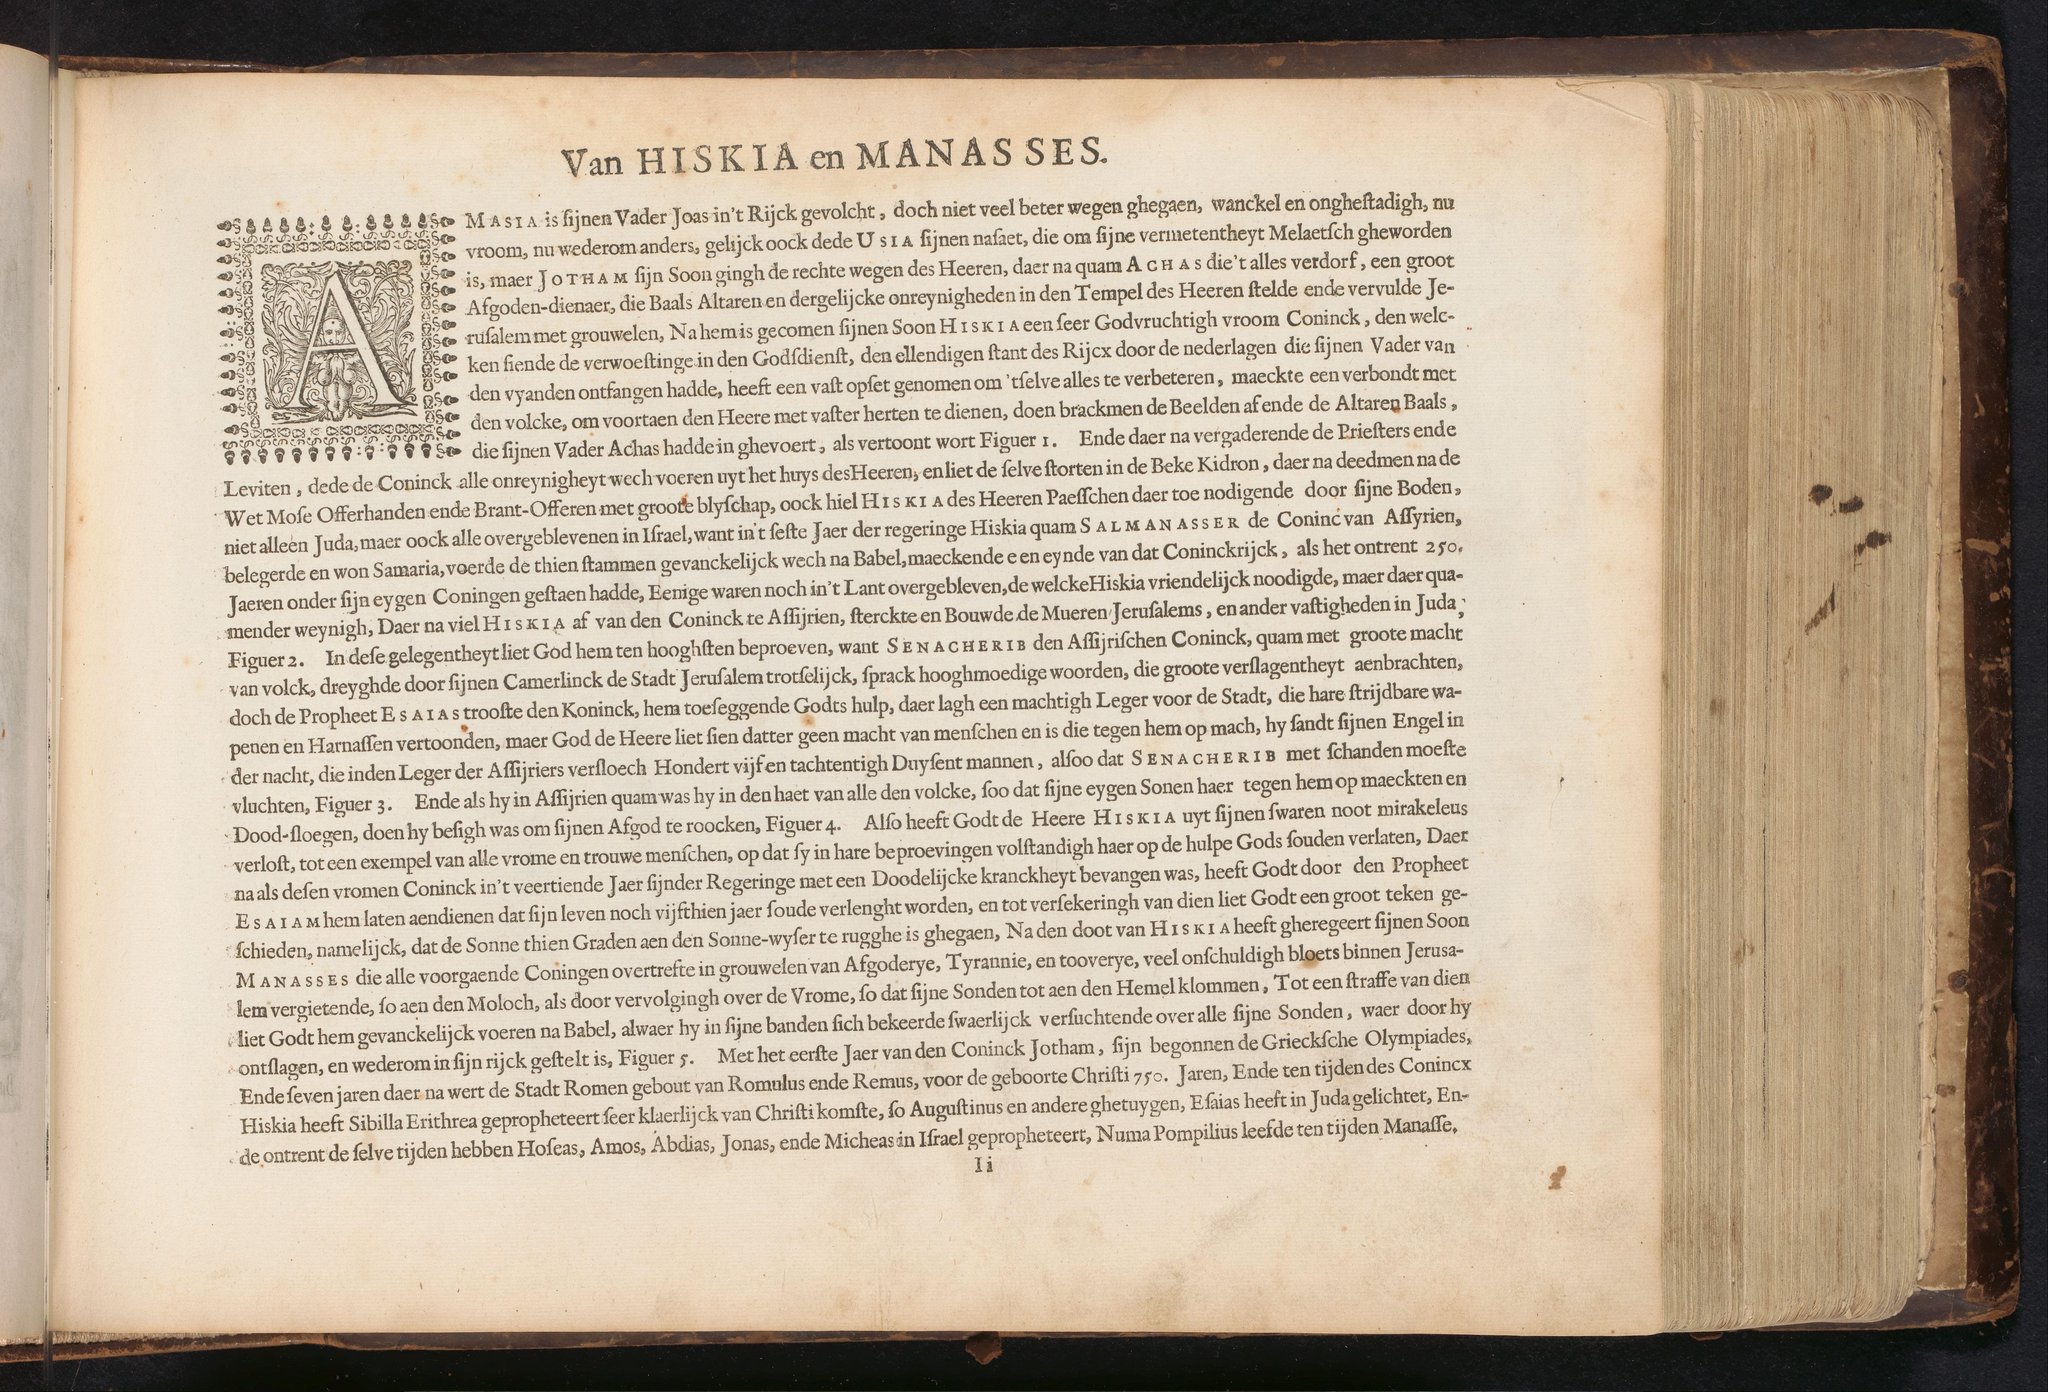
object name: album leaf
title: Den Grooten Figuer-Bibel (...)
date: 1646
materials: paper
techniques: letterpress printing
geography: alkmaar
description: Tekstblad bij een serie prenten over de geschiedenis van Hizkia en Sanherib. Linksboven initiaal A. Dit blad maakt deel uit van een album.